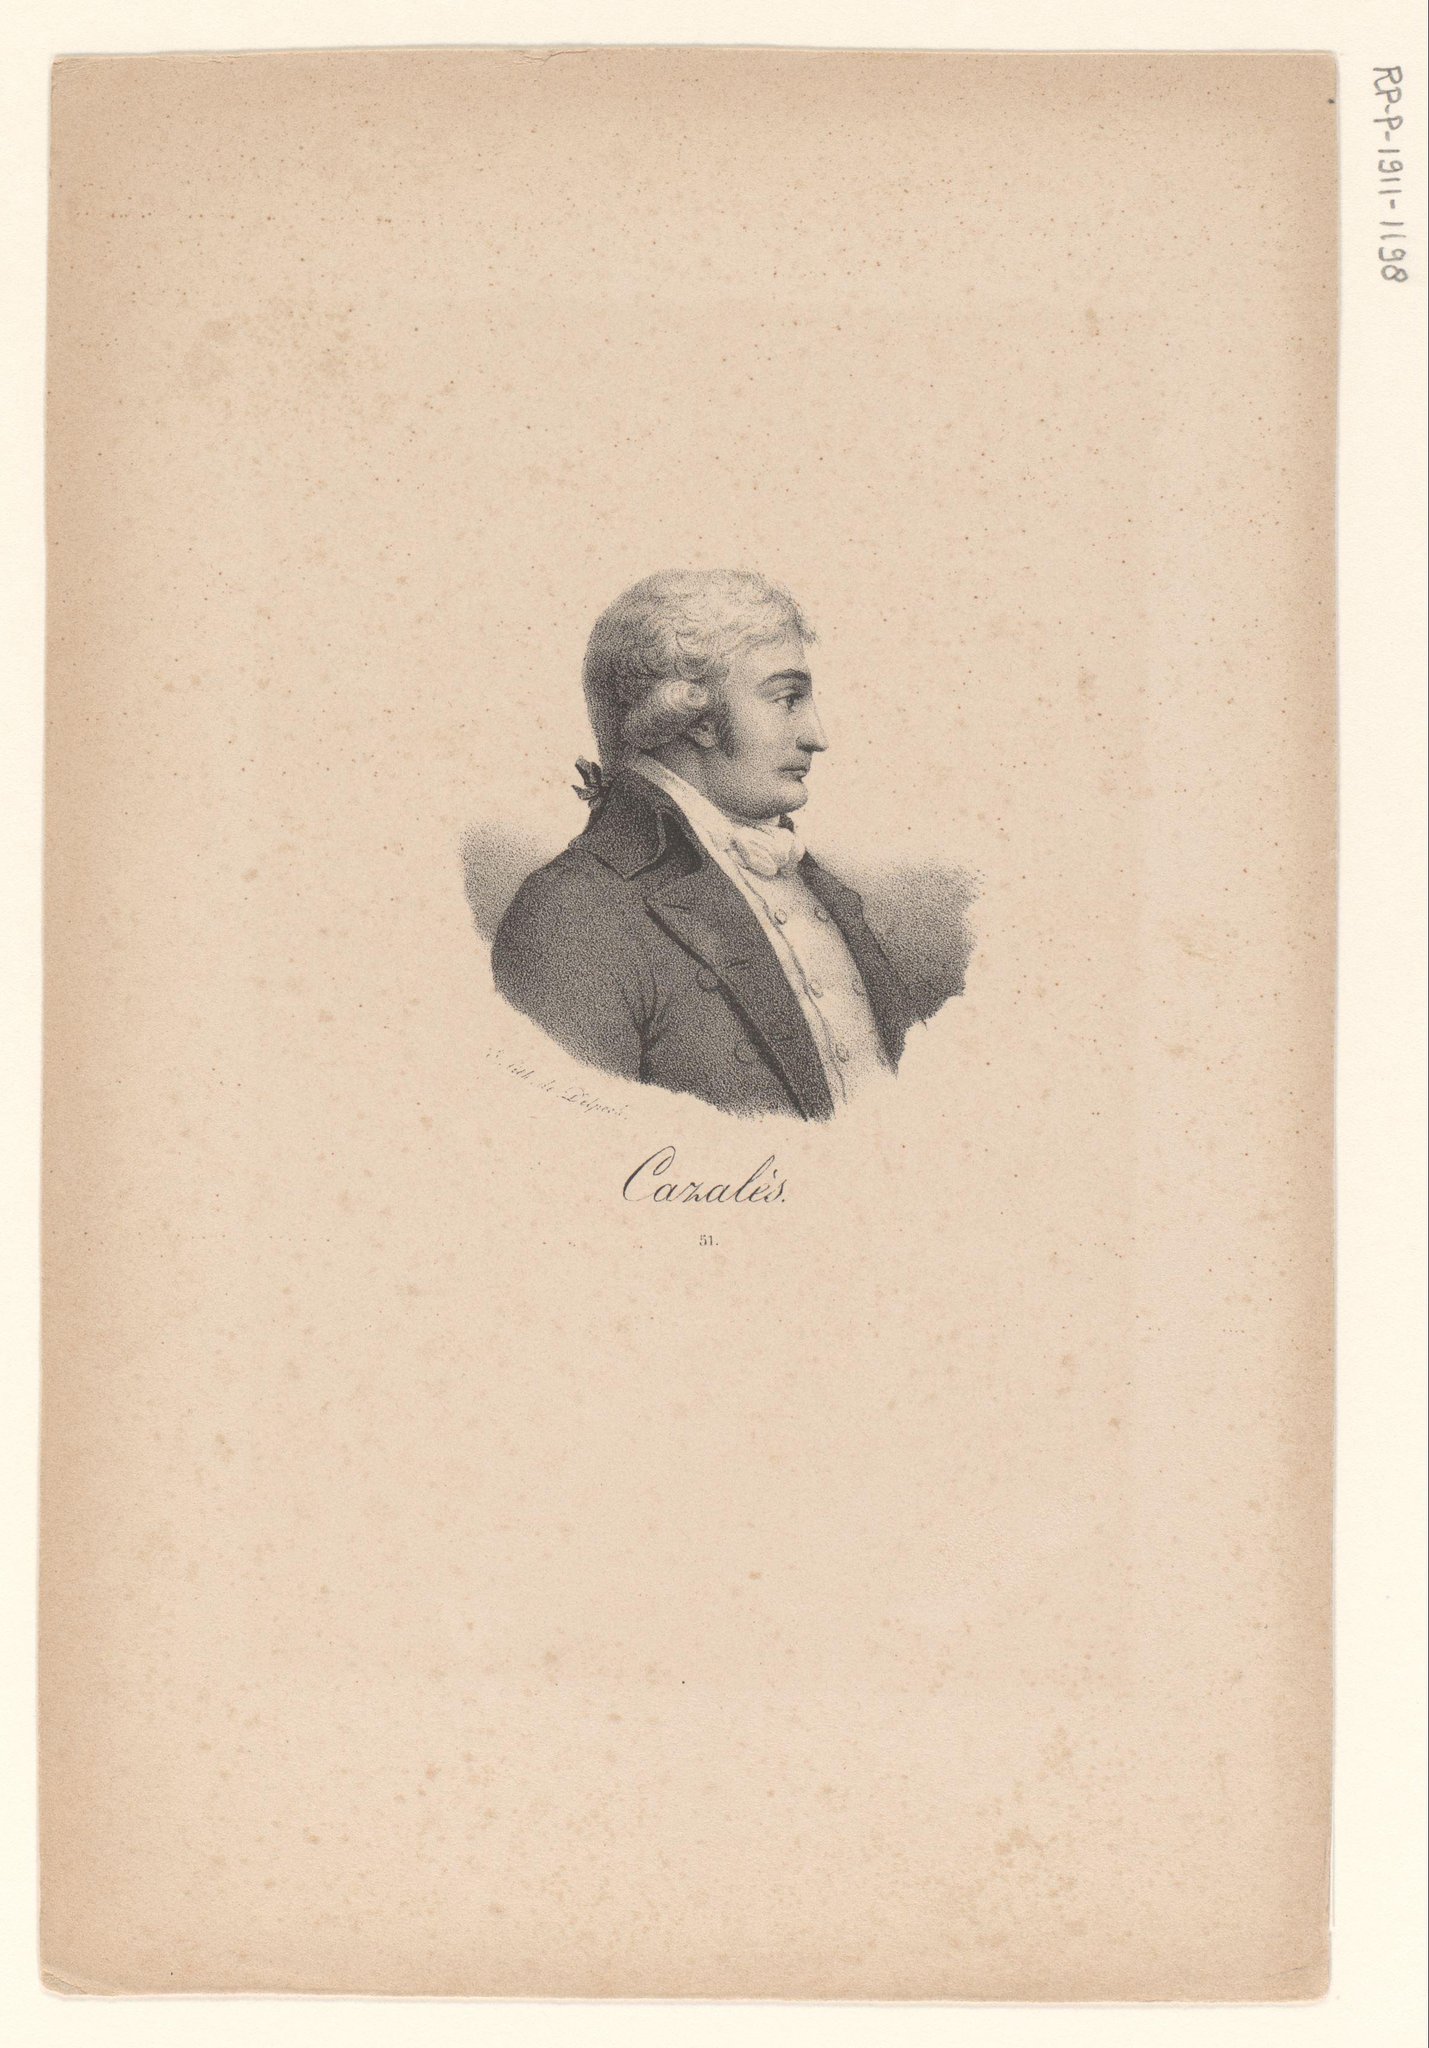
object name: print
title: Portret van Jacques Antoine Marie de Cazalès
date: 1818-1842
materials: paper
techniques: lithograph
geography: paris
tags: politician, historical persons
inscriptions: collector's mark: Lugt 2228a